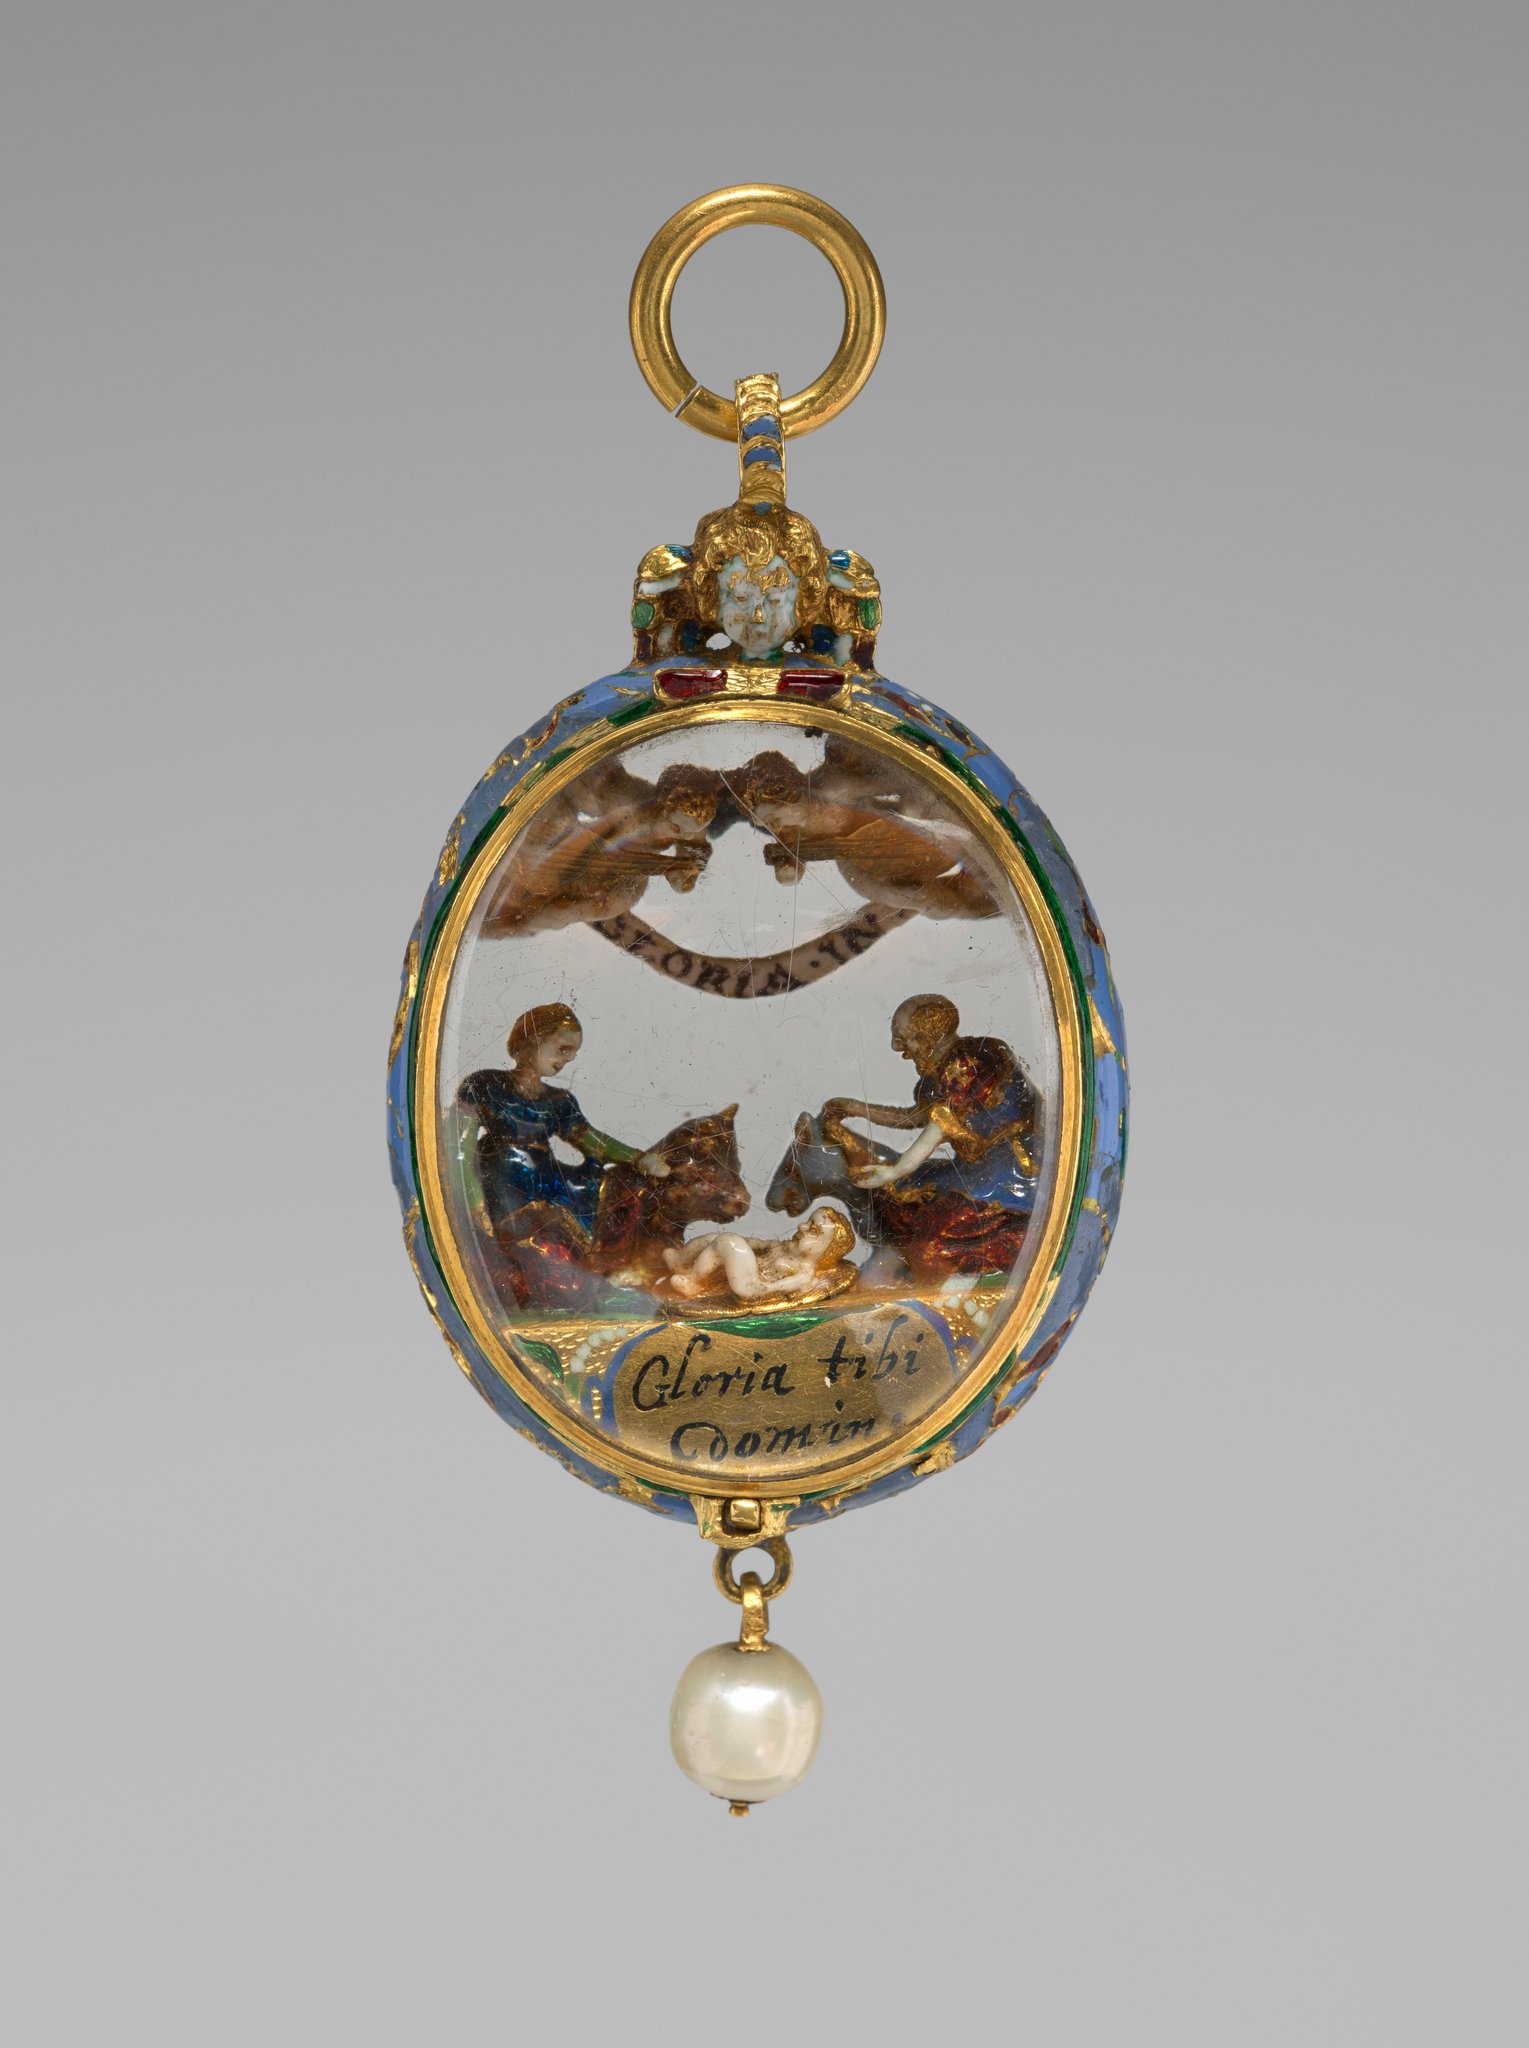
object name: pendant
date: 1501-1600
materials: gold, pearl, quartz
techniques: enamel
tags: animals,women